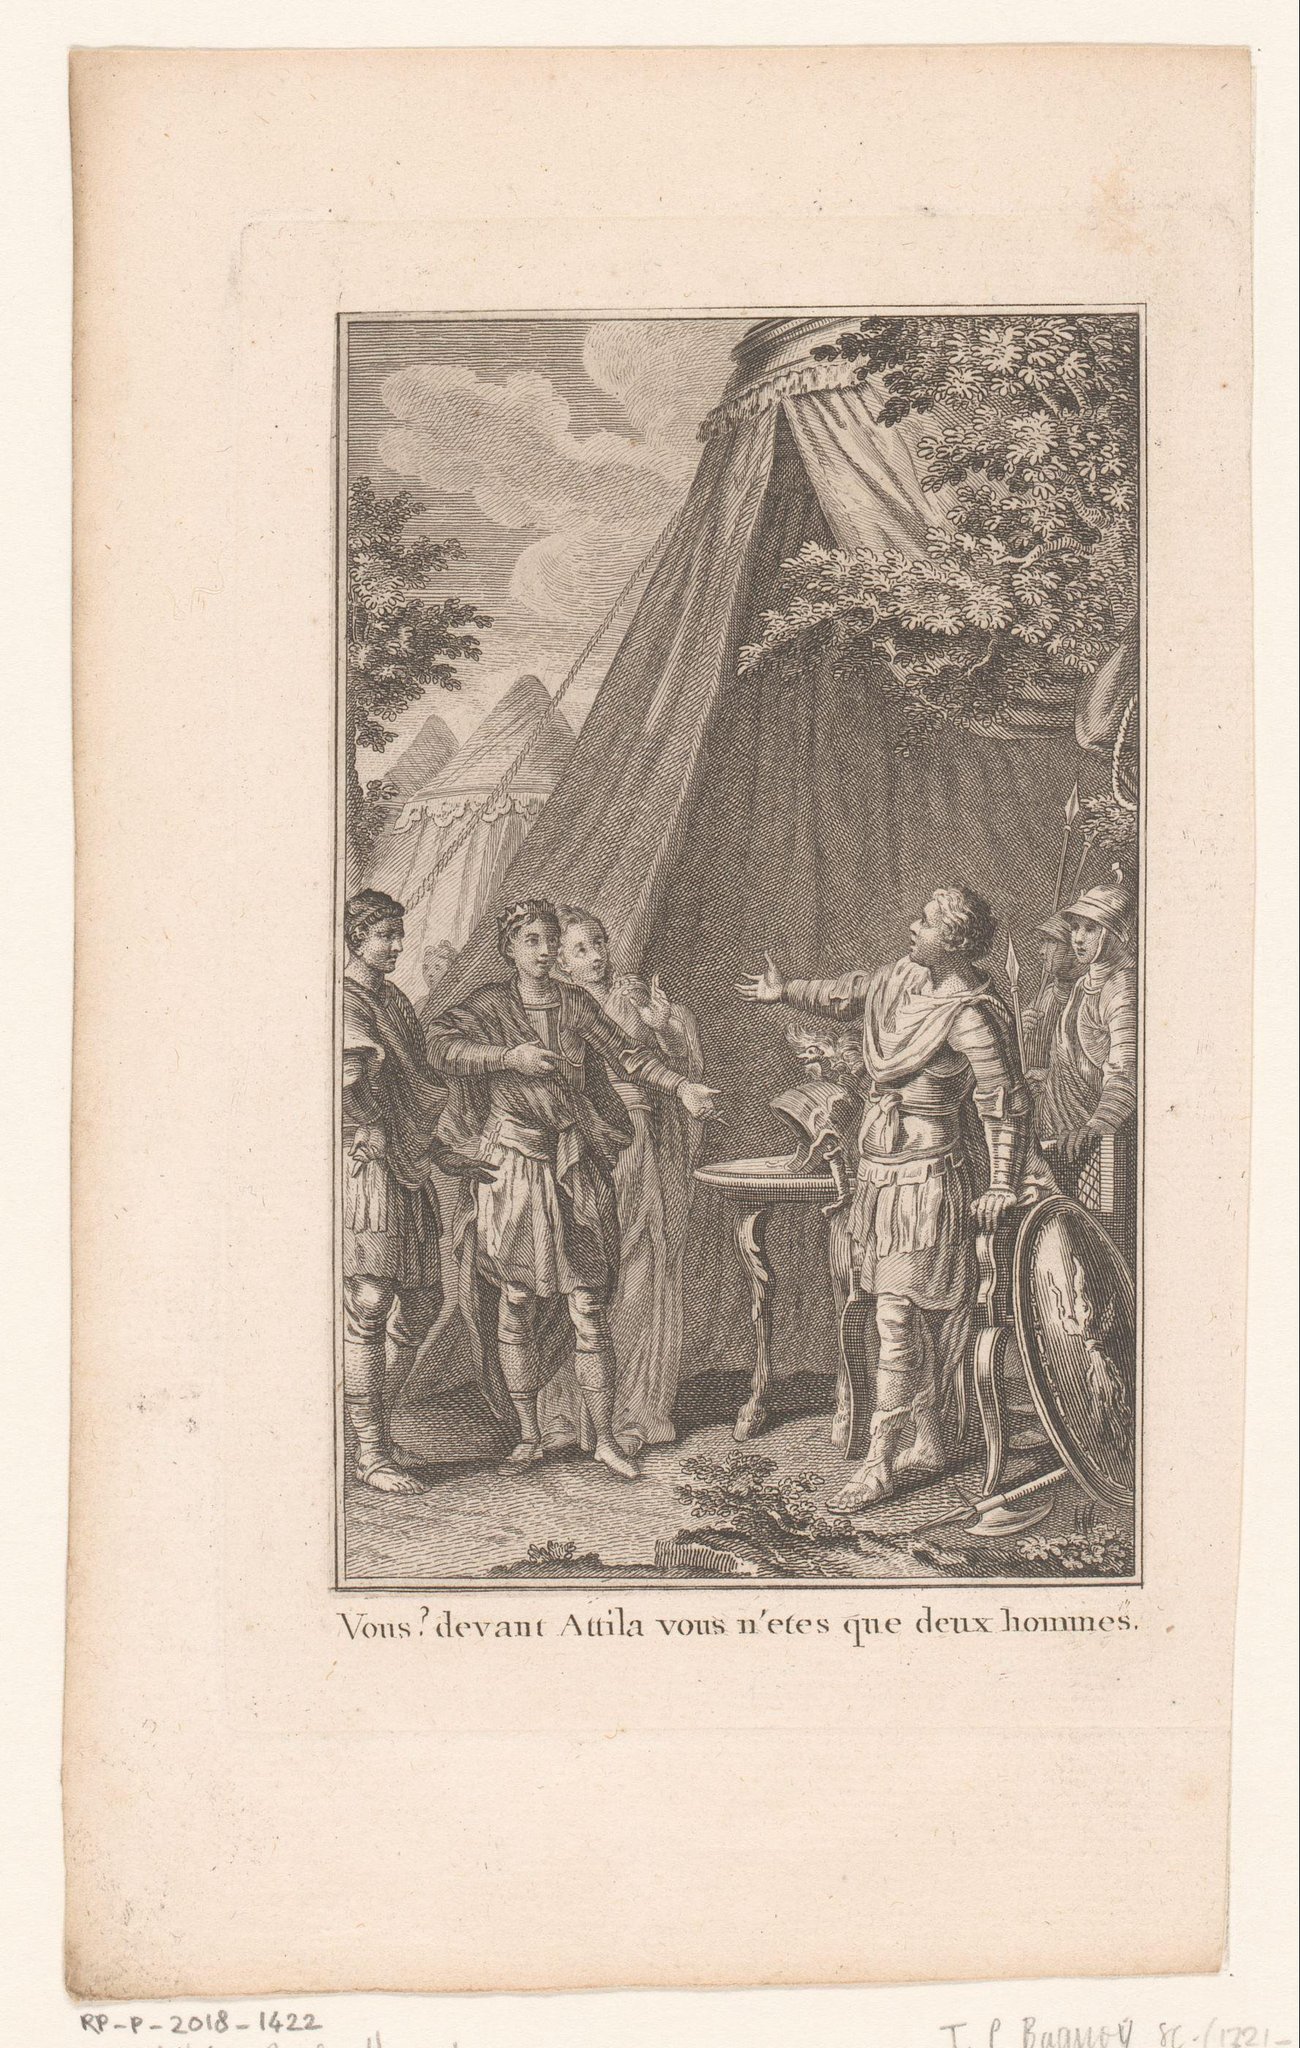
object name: print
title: Scène uit Attila met figuren bij een legertent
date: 1764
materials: paper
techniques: engraving, etching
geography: geneva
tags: theatre, theatrical performance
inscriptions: collector's mark: Lugt 2228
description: Prent uit: Corneille, Pierre. Théâtre (...). Genève: Cramer, 1764. Dit betreft een illustratie op p. 1 uit deel 9, getiteld 'Attila'.